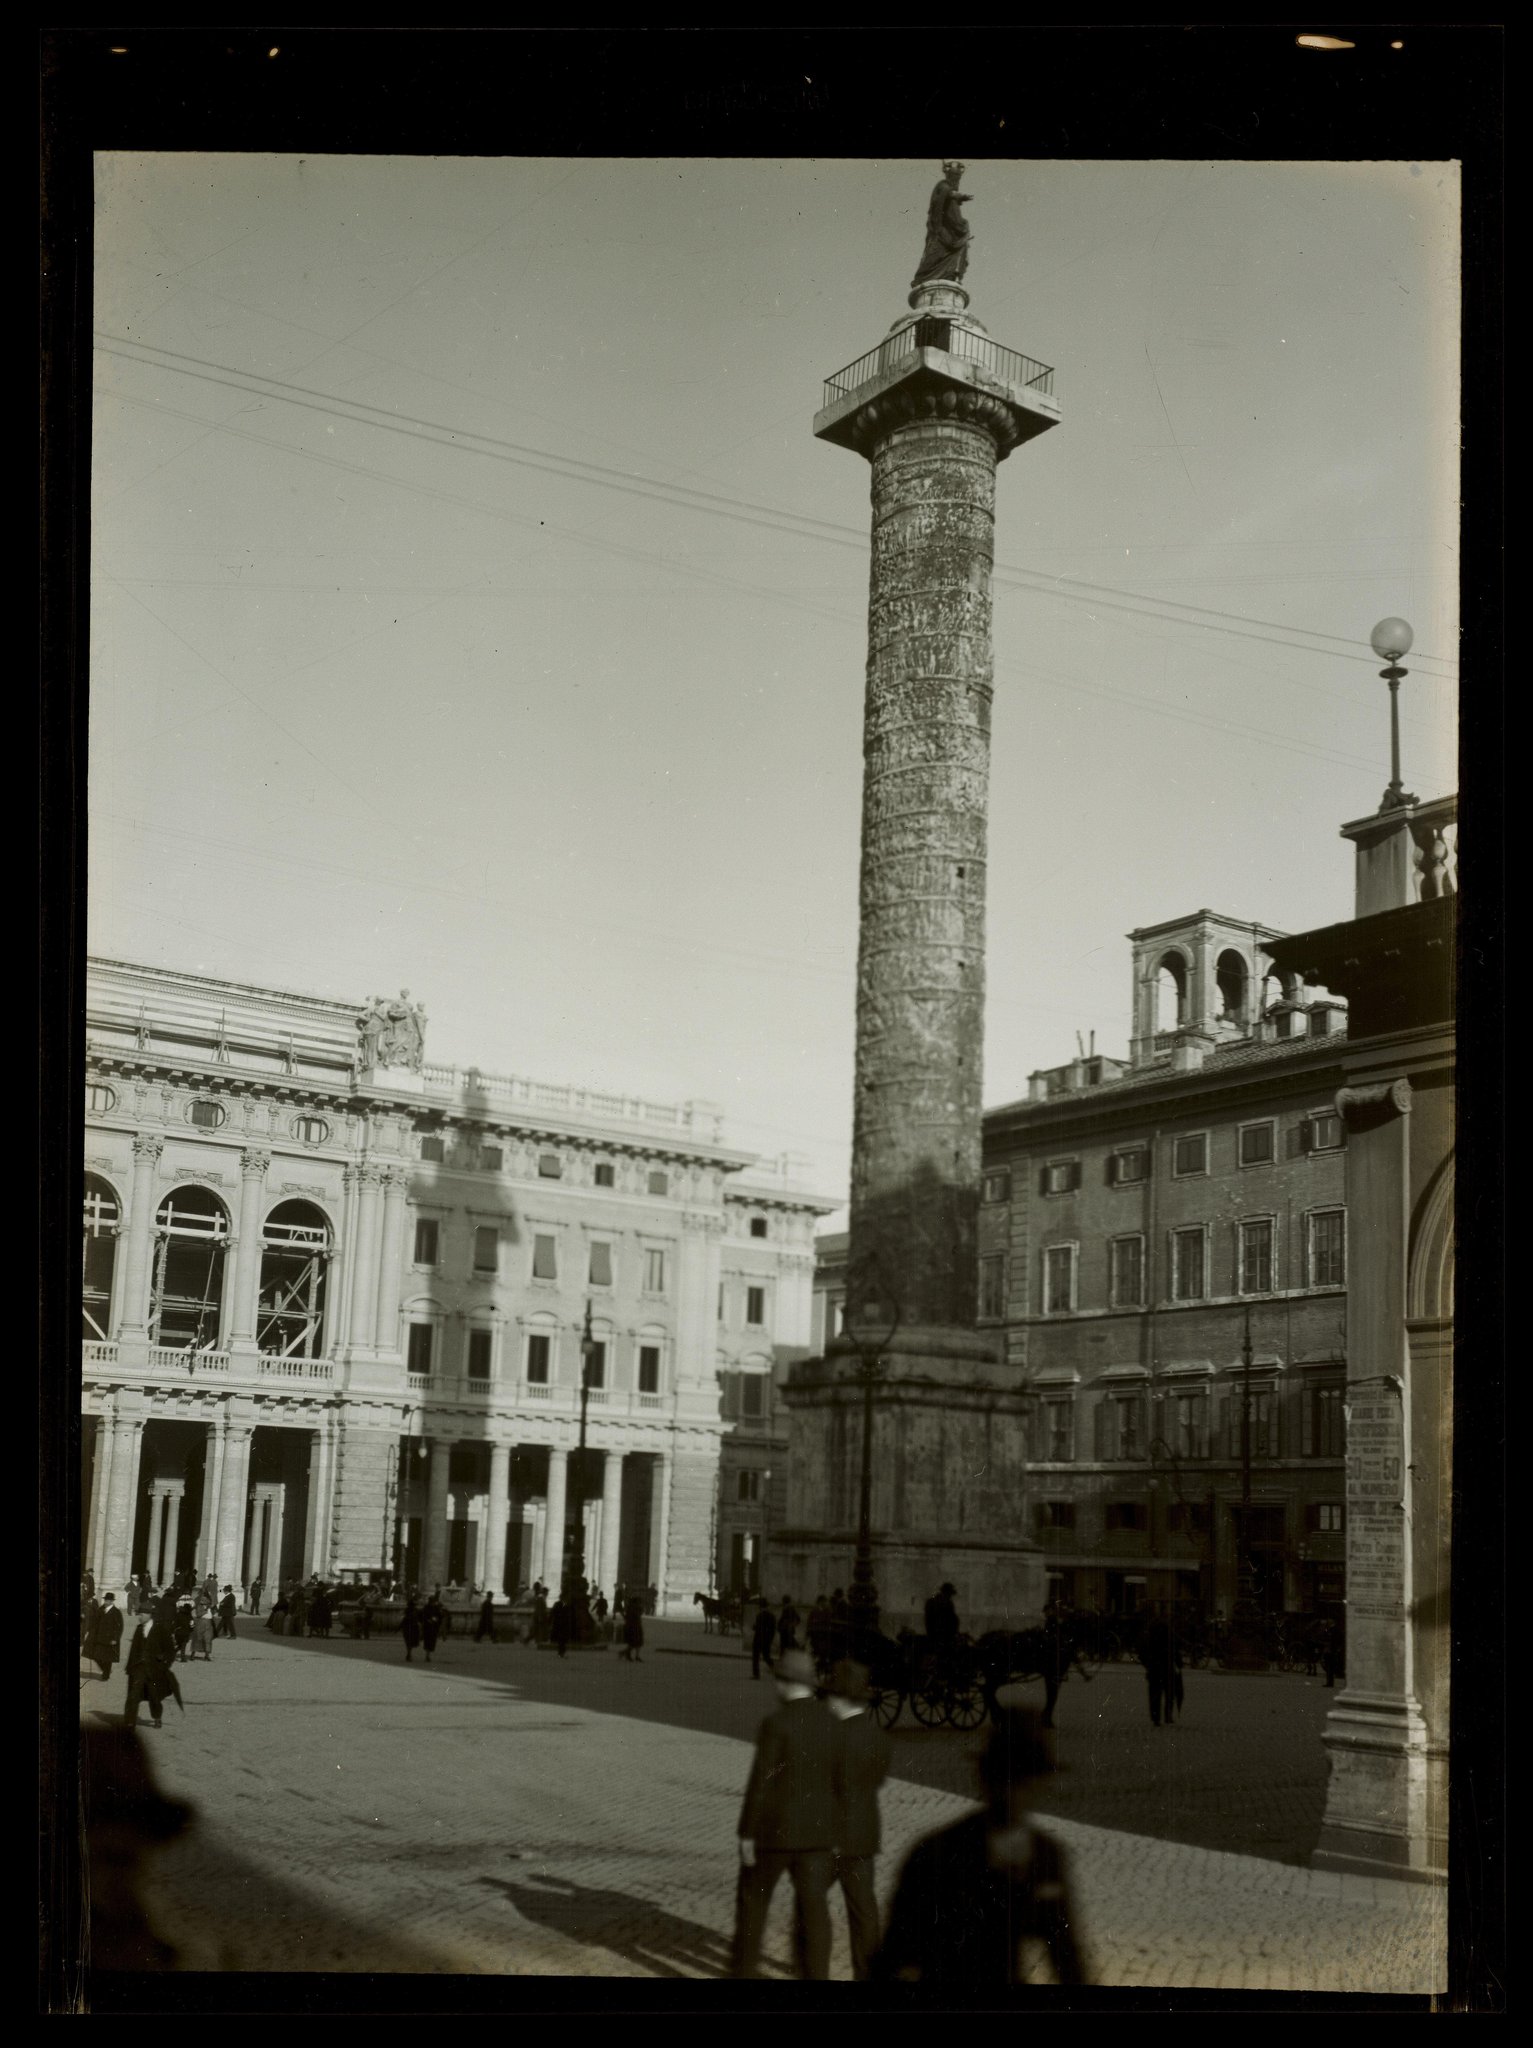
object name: negative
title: Filmnegatief met opname van Rome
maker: Anonymous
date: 1907-1935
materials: film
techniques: gelatin silver negative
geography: rome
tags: rome